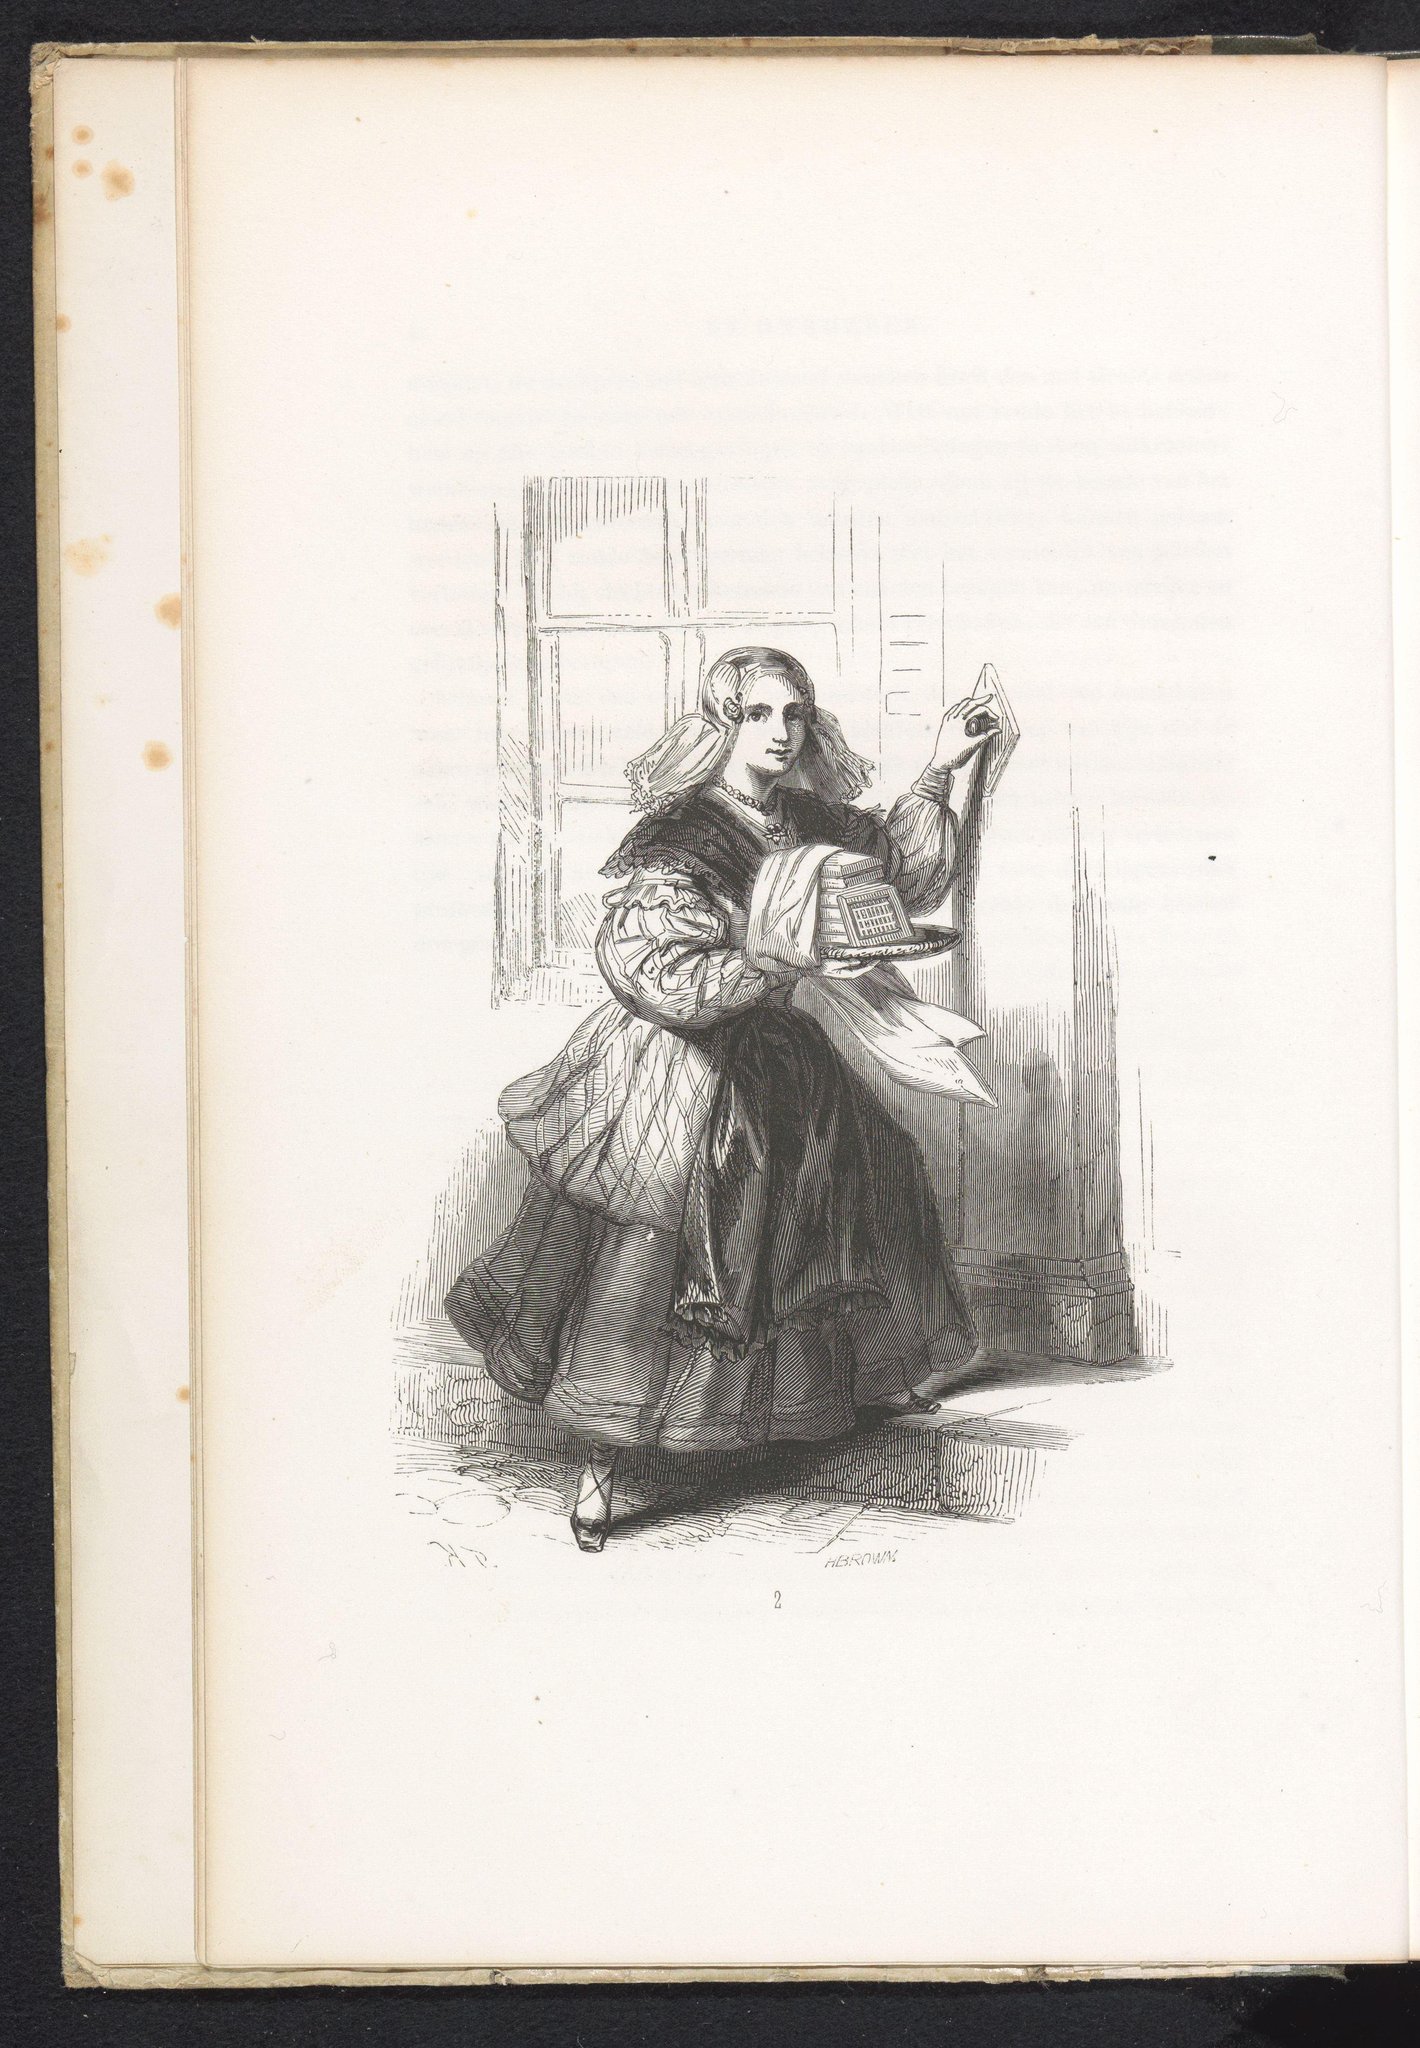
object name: book illustration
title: Het wafelmeisje, 1840-1841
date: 1841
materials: paper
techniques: letterpress printing, engraving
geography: netherlands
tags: professional clothes, wandering or travelling merchant - bb - women engaged in trade and commerce, waffles, netherlands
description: Een meisje belt aan bij een huis om er wafels te verkopen. Genummerd: 2. Illustratie in het boek 'De Nederlanden: karakterschetsen, kleederdrachten, houding en voorkomen van verschillende standen', een boek met karakterschetsen, beroepen en klederdrachten van Nederlandse volkstypen uit 1841.